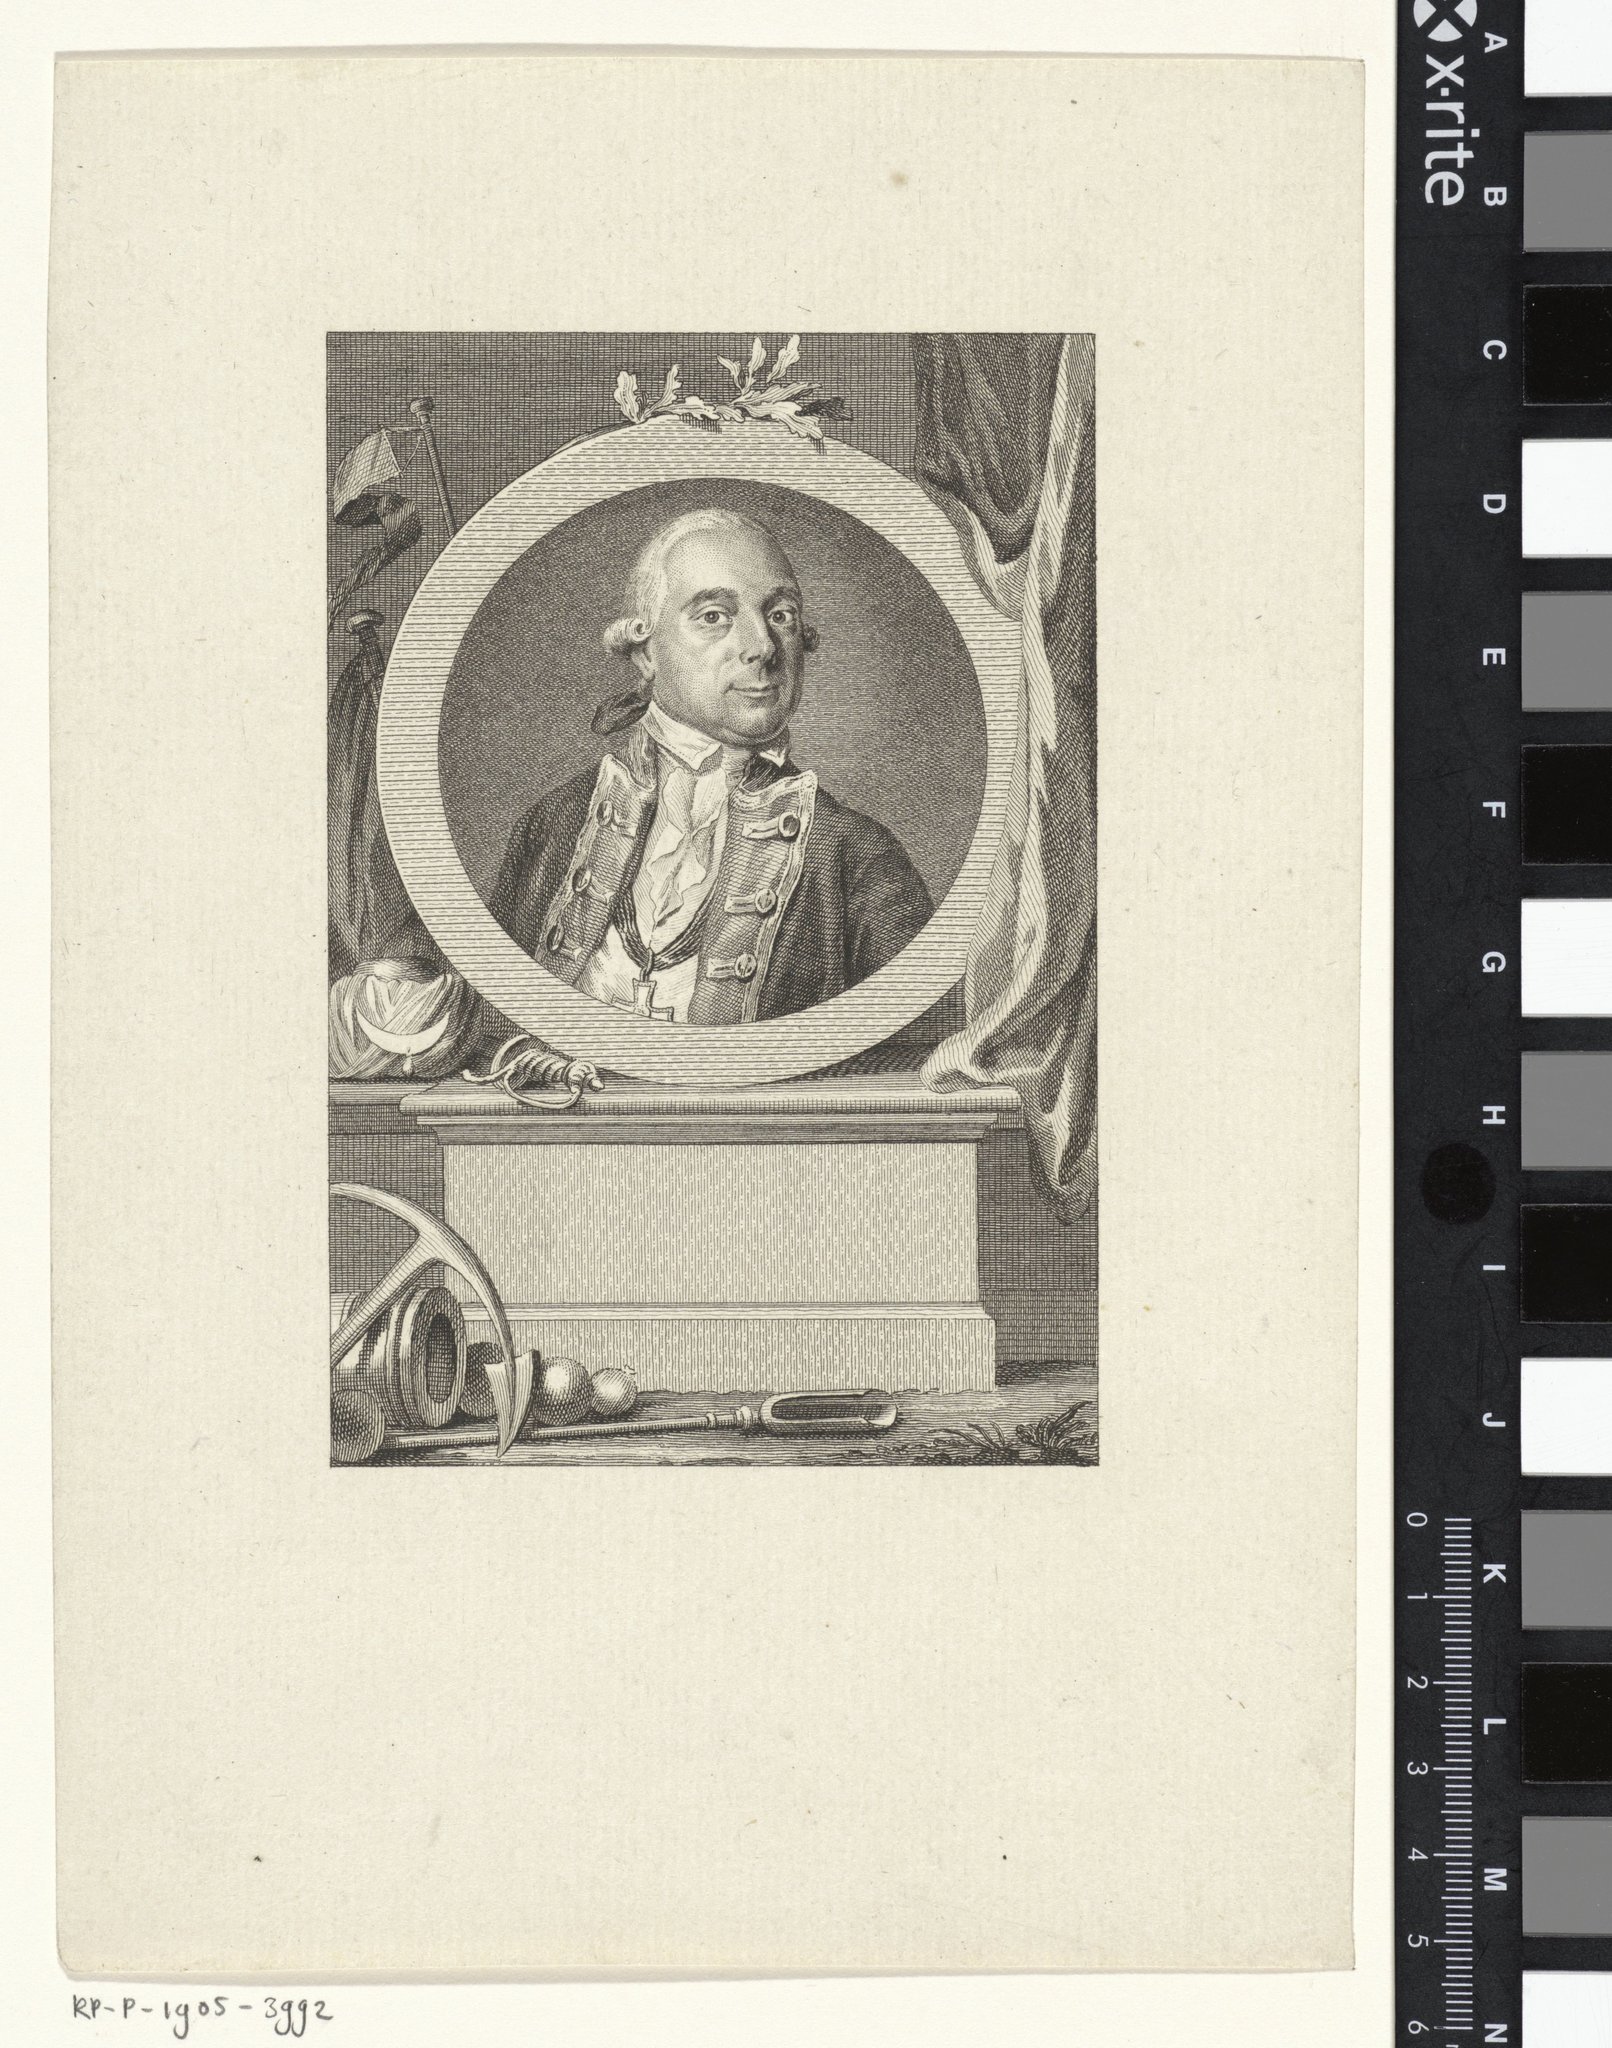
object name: print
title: Portret van de admiraal Jan Hendrik van Kinsbergen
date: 1781-1816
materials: paper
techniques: etching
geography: amsterdam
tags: jonkheer jan hendrik van kinsbergen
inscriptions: collector's mark: Lugt 2228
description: Portret van Jan Hendrik van Kinsbergen, vice-admiraal en buitengewoon maarschalk der Hollandse zeemacht.